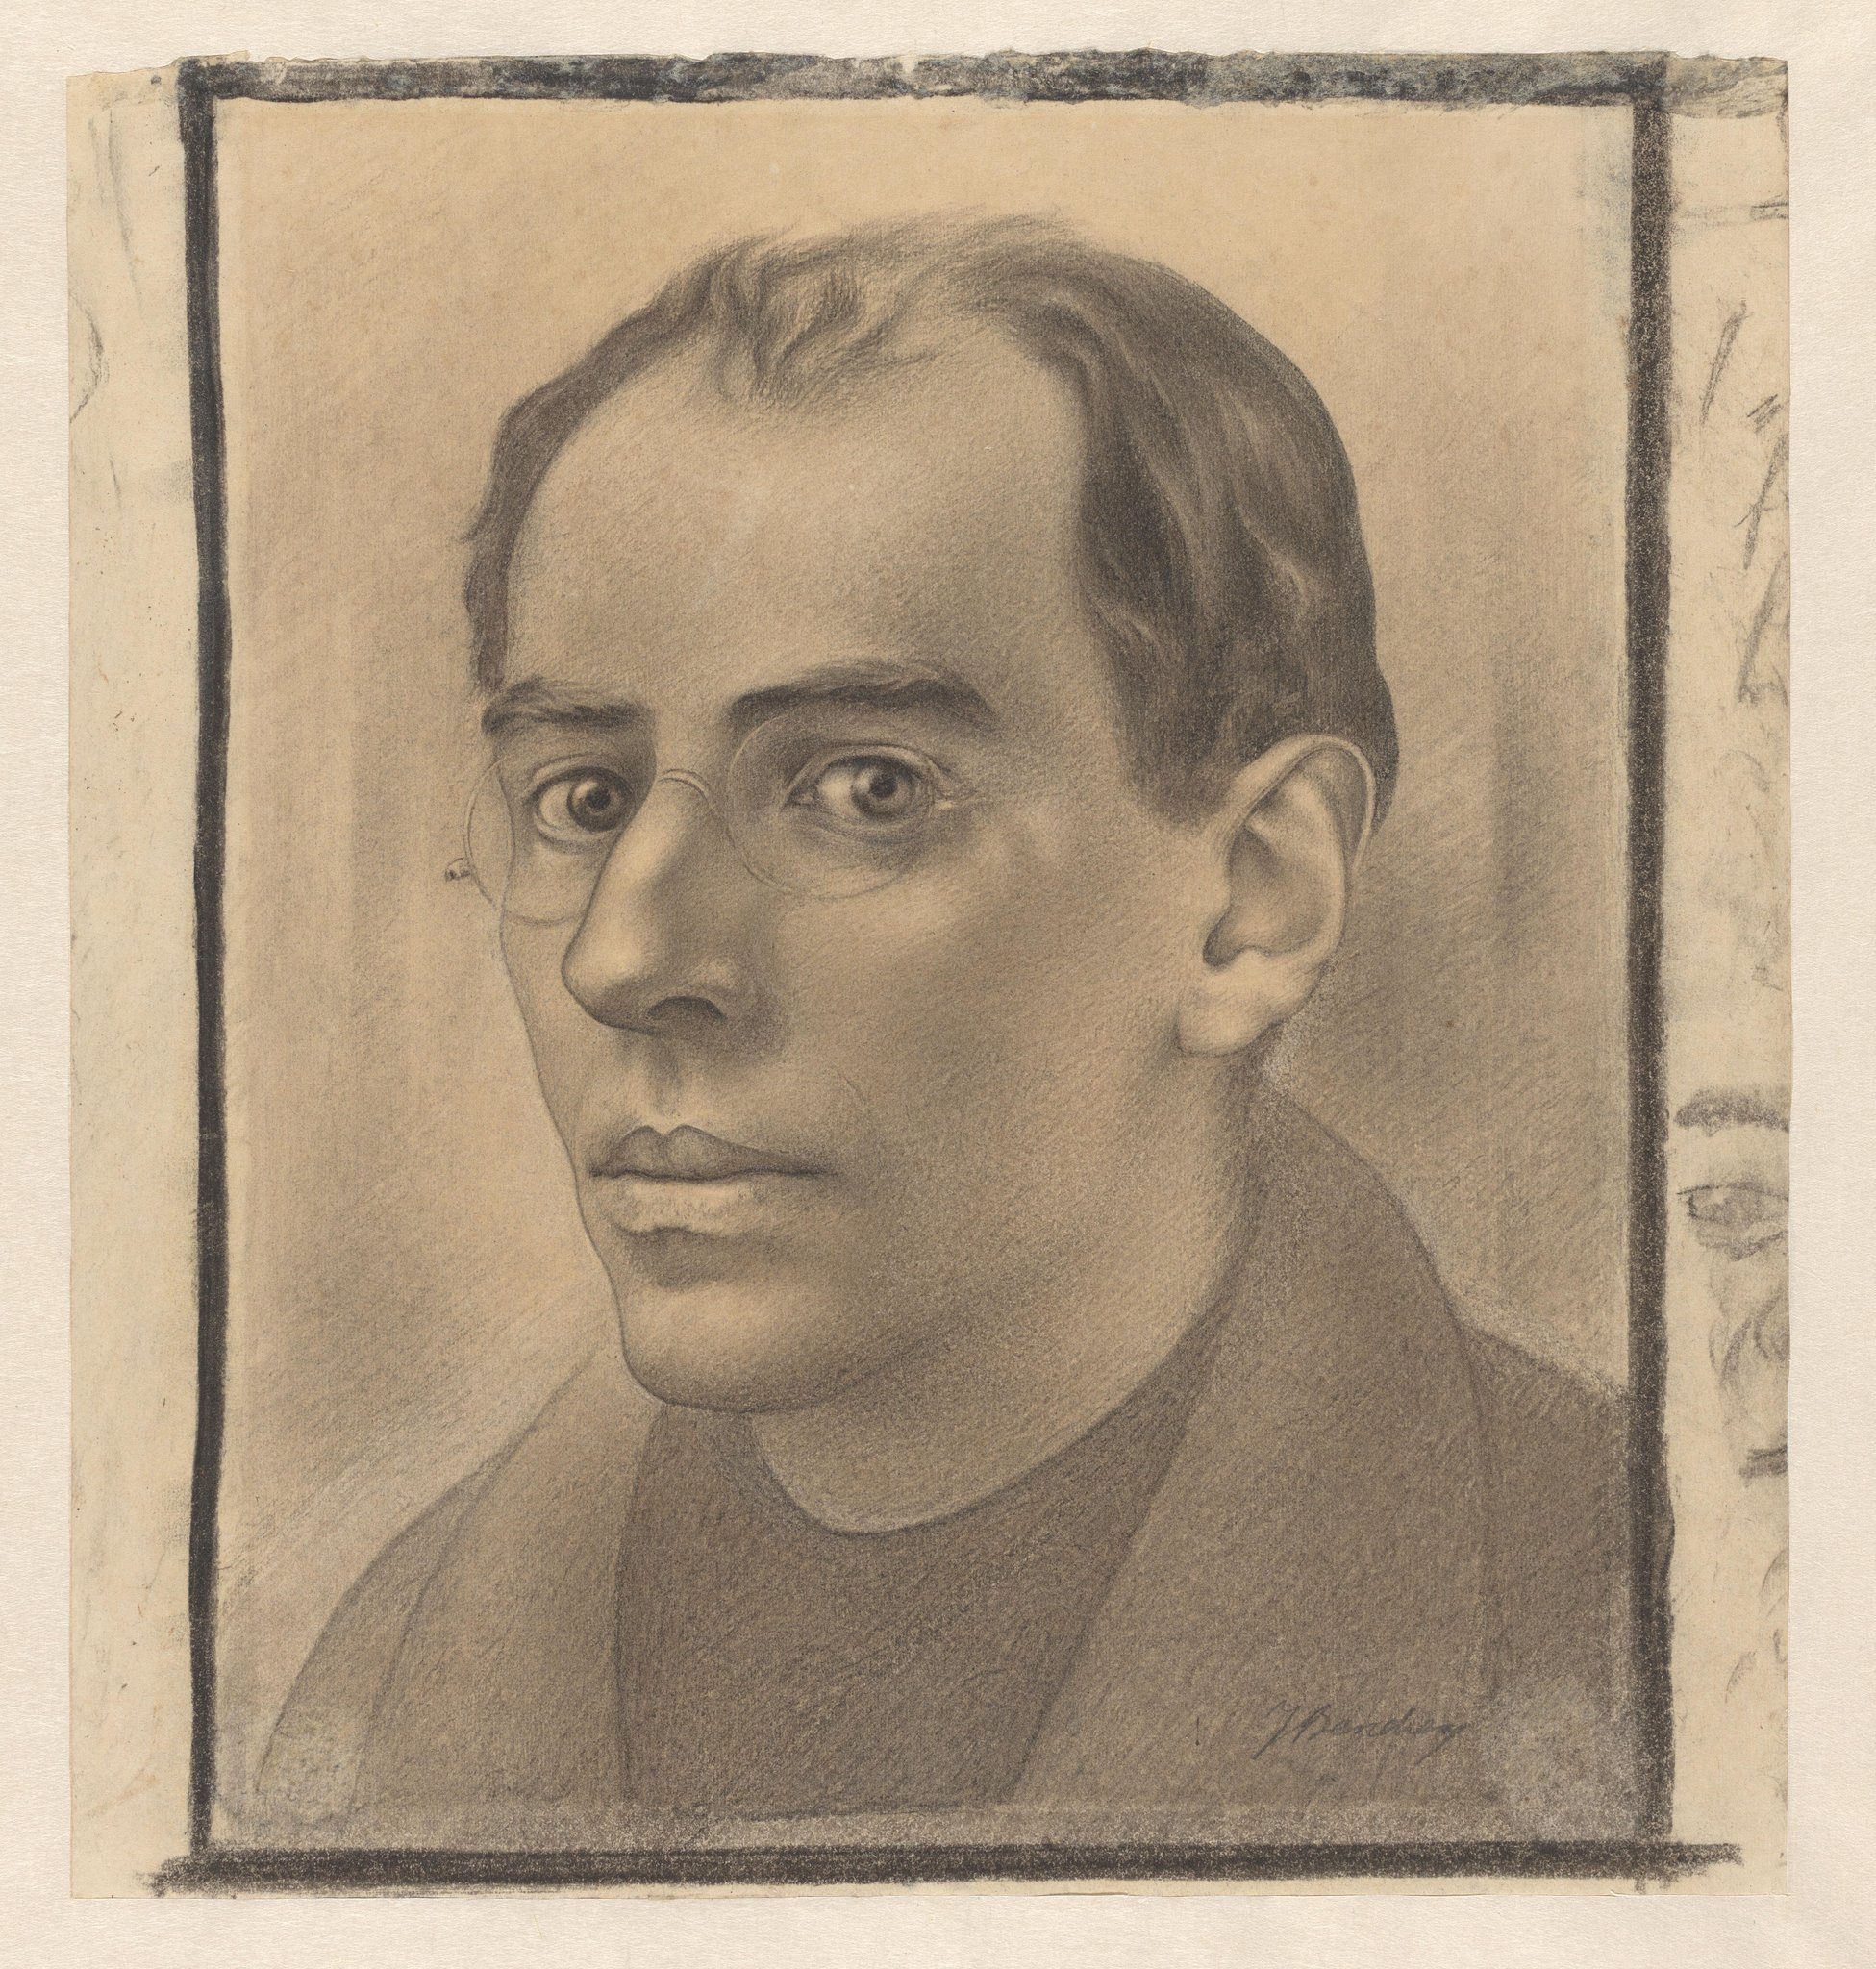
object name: drawing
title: Zelfportret Jacob Bendien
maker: jacob bendien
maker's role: draughtsman, print maker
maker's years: 1890-1933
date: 1909-1927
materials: charcoal, paper, pencil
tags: amsterdam, print maker, draughtsman, jacob bendien, portrait, self-portrait of artist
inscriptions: signature: ‘JBendien’